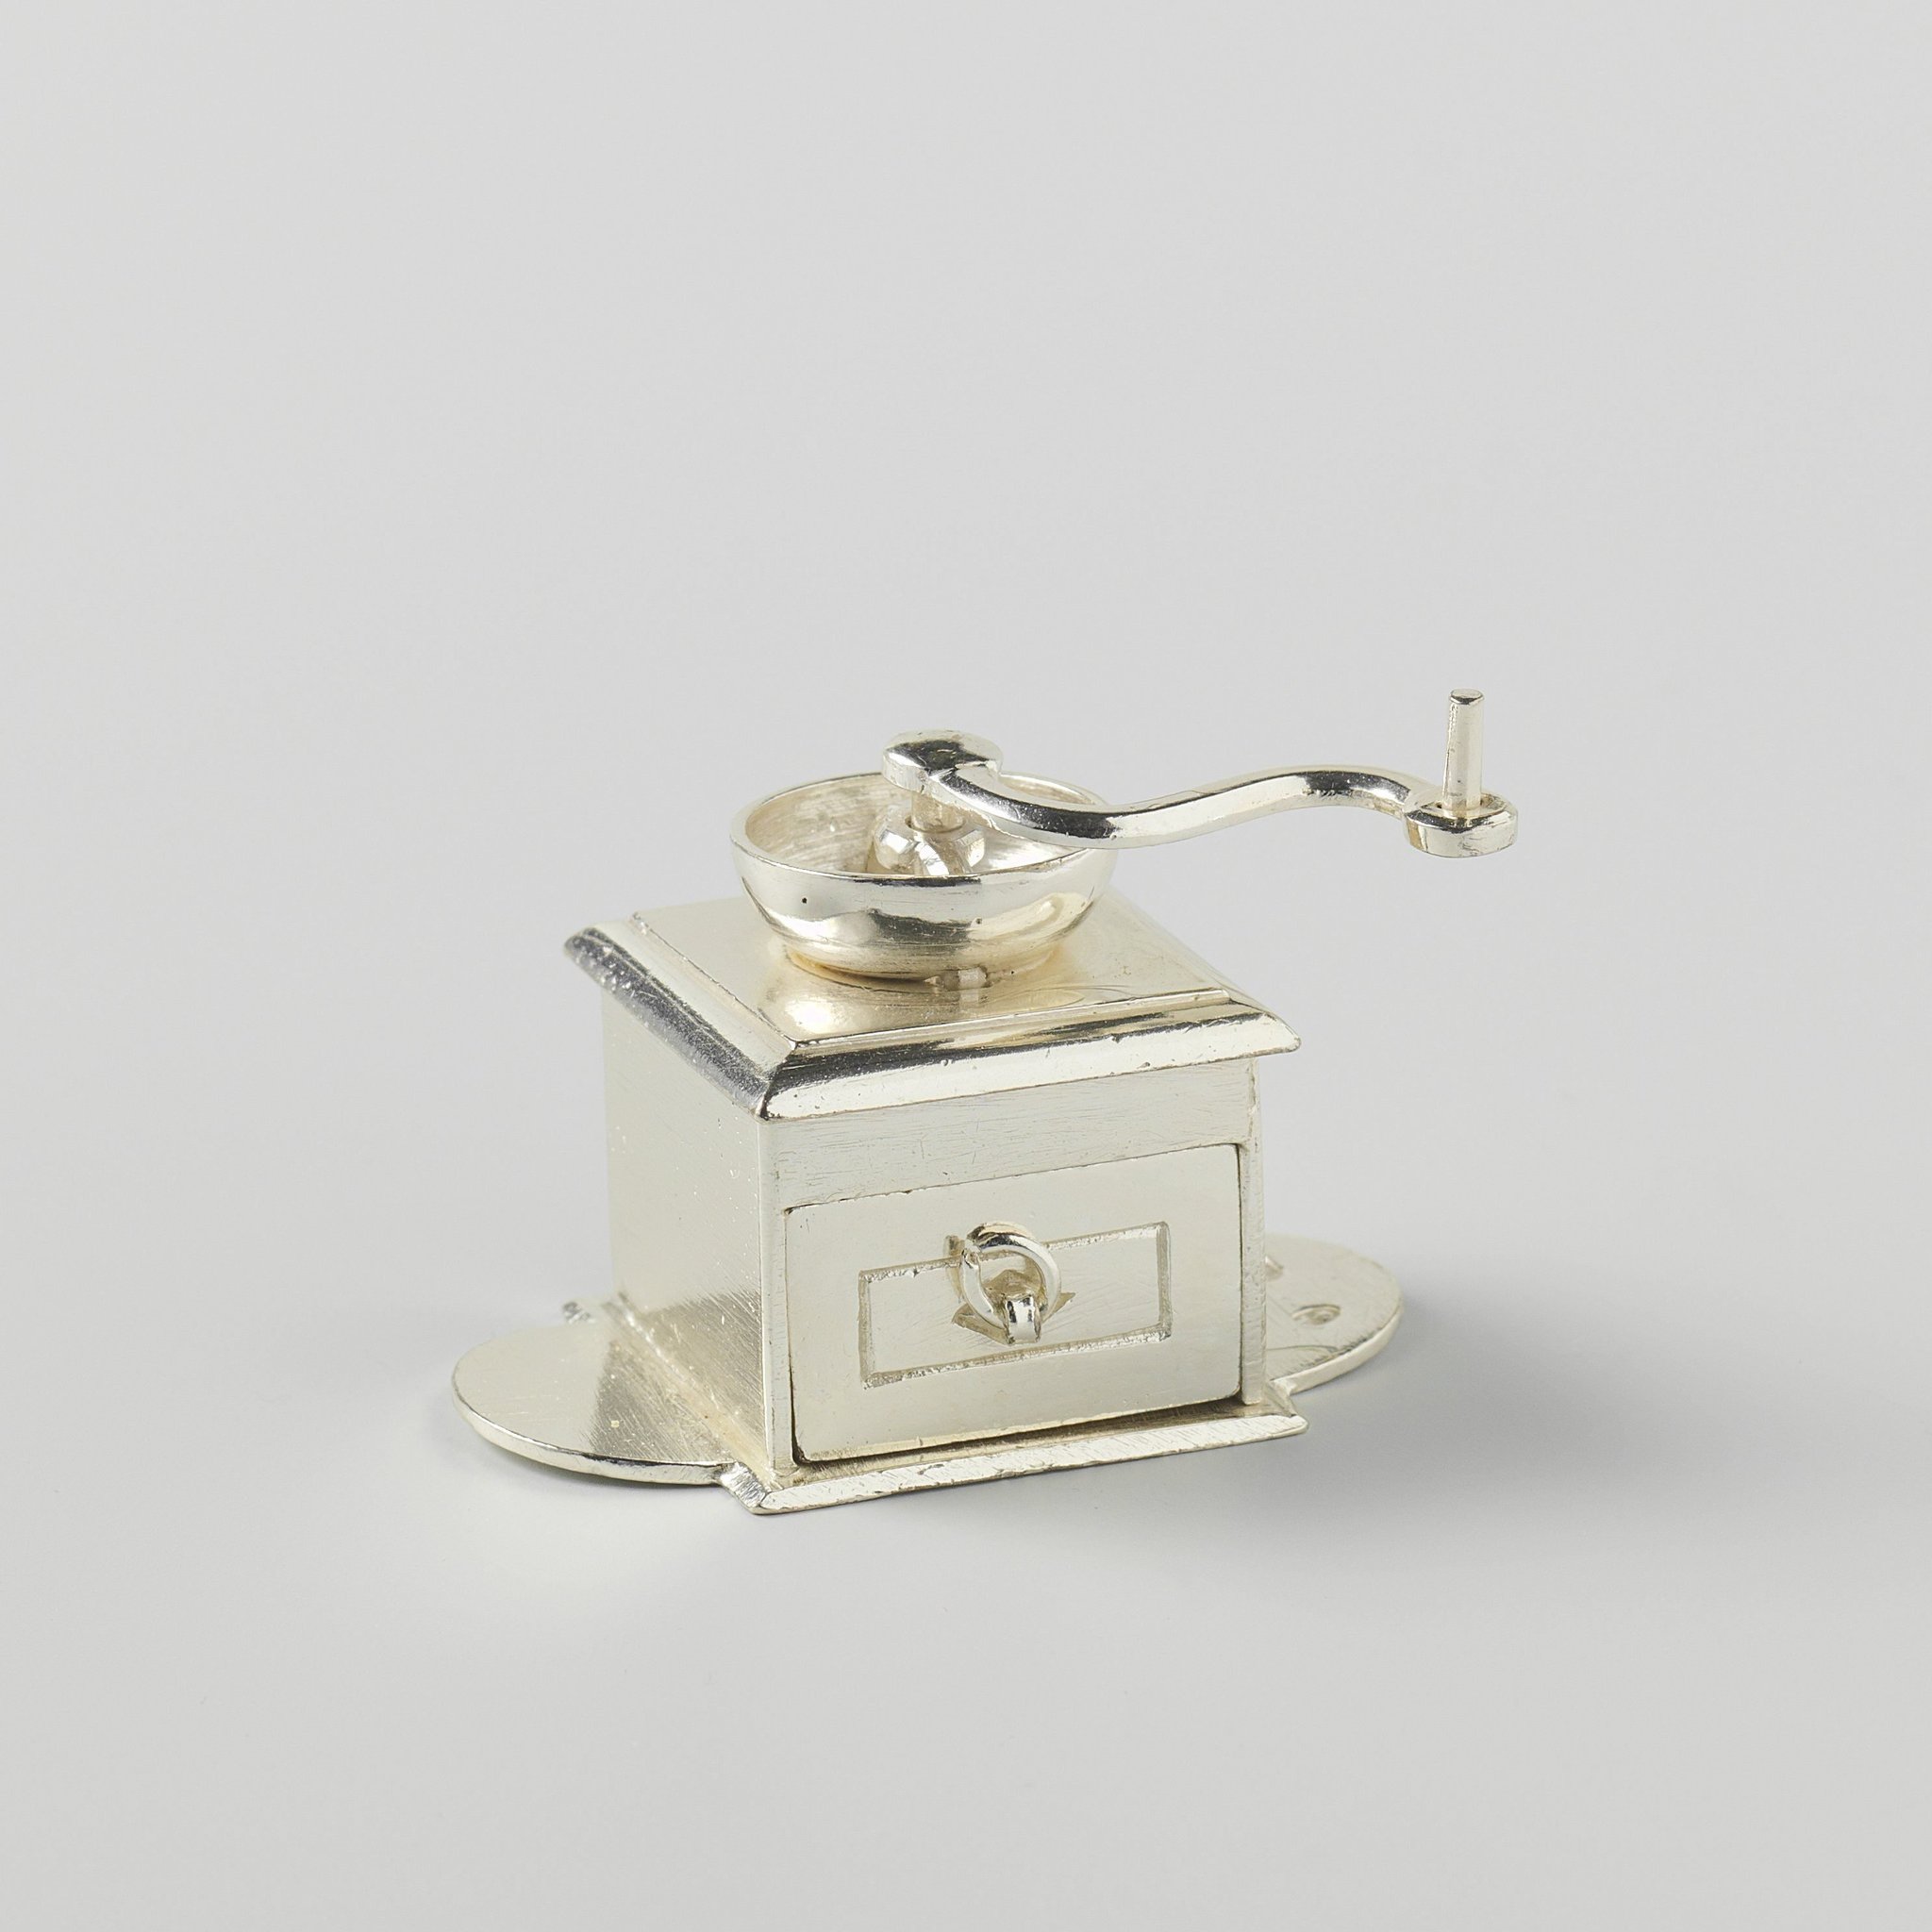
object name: miniature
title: Koffiemolen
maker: jan rooseboom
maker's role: silversmith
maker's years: 1698-1773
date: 1730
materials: silver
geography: amsterdam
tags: tea- and coffee-service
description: Koffiemolen met zwengel en lade. De knop van de zwengel ontbreekt. In de voorzijde van de lade is een rechthoek gegraveerd, in het midden van deze rechthoek zit een ring. De koffiemolen is gemerkt: stk.= Amsterdam, mt.= Jan Rooseboom en een zwijnskop.